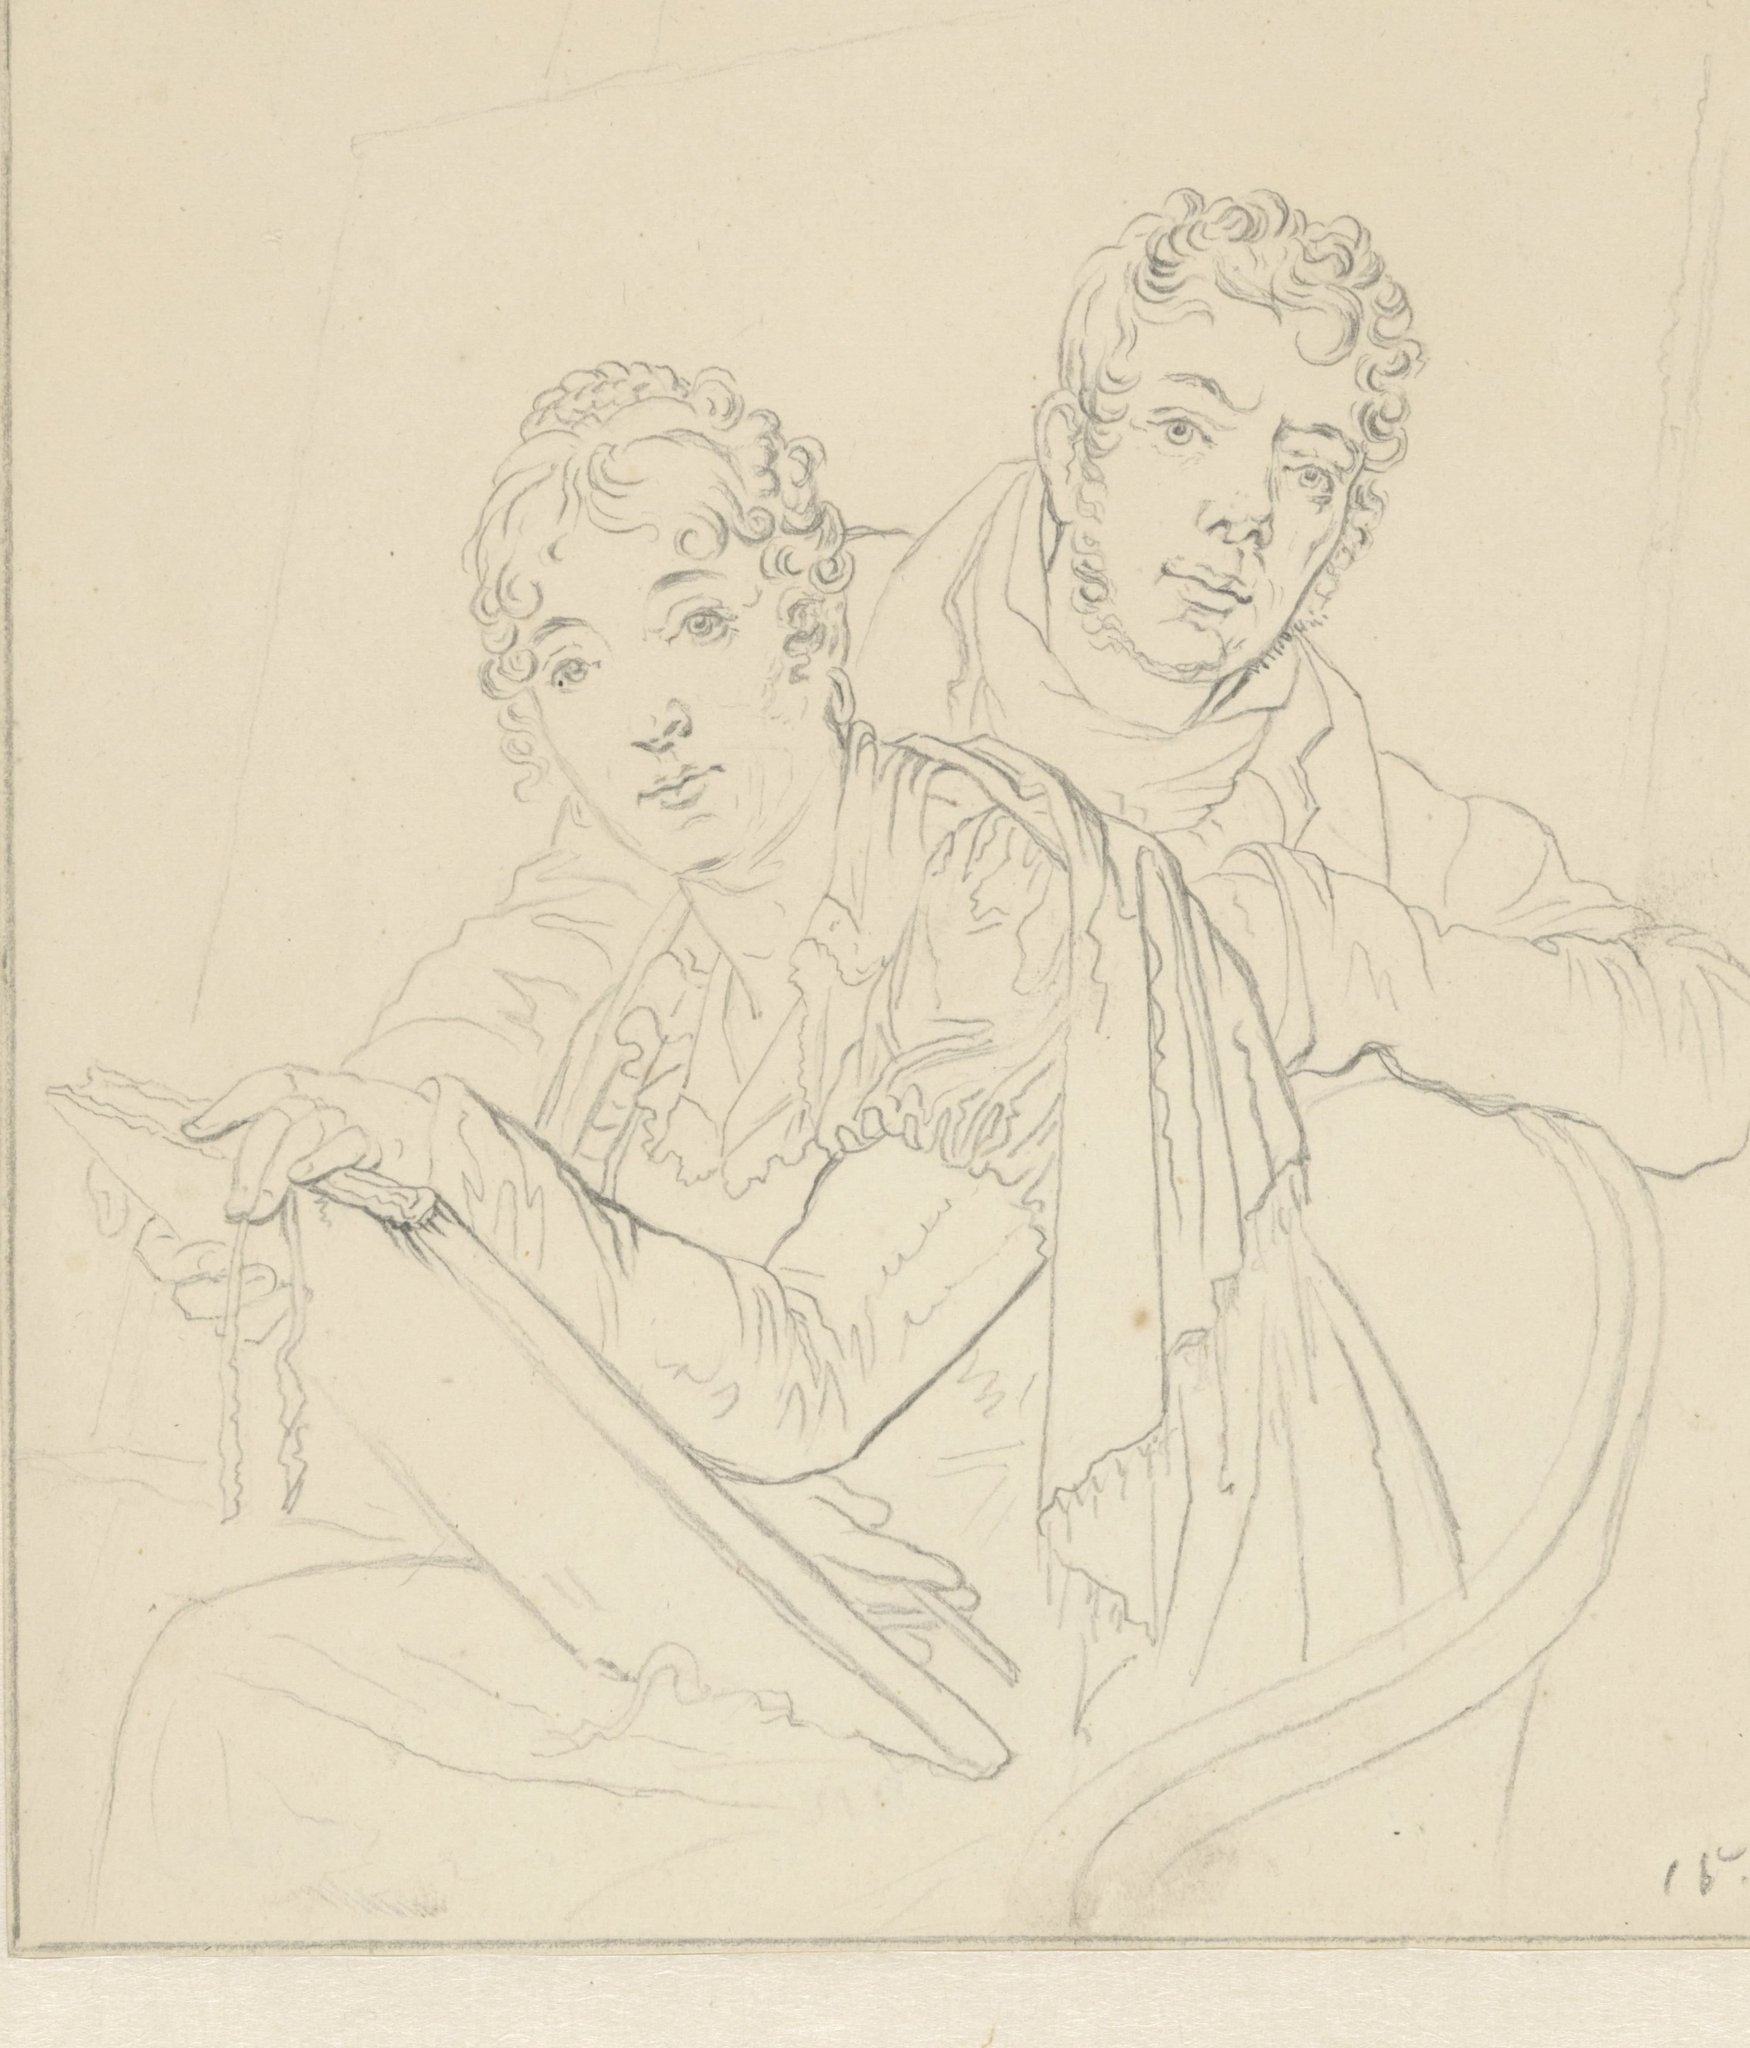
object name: drawing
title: Zelfportret van Louis Moritz met zijn vrouw Anna Reijermans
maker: louis moritz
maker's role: draughtsman, painter, print maker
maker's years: 1773-1850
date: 1810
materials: paper, pencil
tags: the hague, amsterdam, painter, print maker, draughtsman, louis moritz, annette reijerman, historical persons - bb - woman, historical persons, portrait, self-portrait of artist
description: De vrouw heeft een tekenmap op schoot en een tekenstift in de hand. Achter het paar een schildersezel.